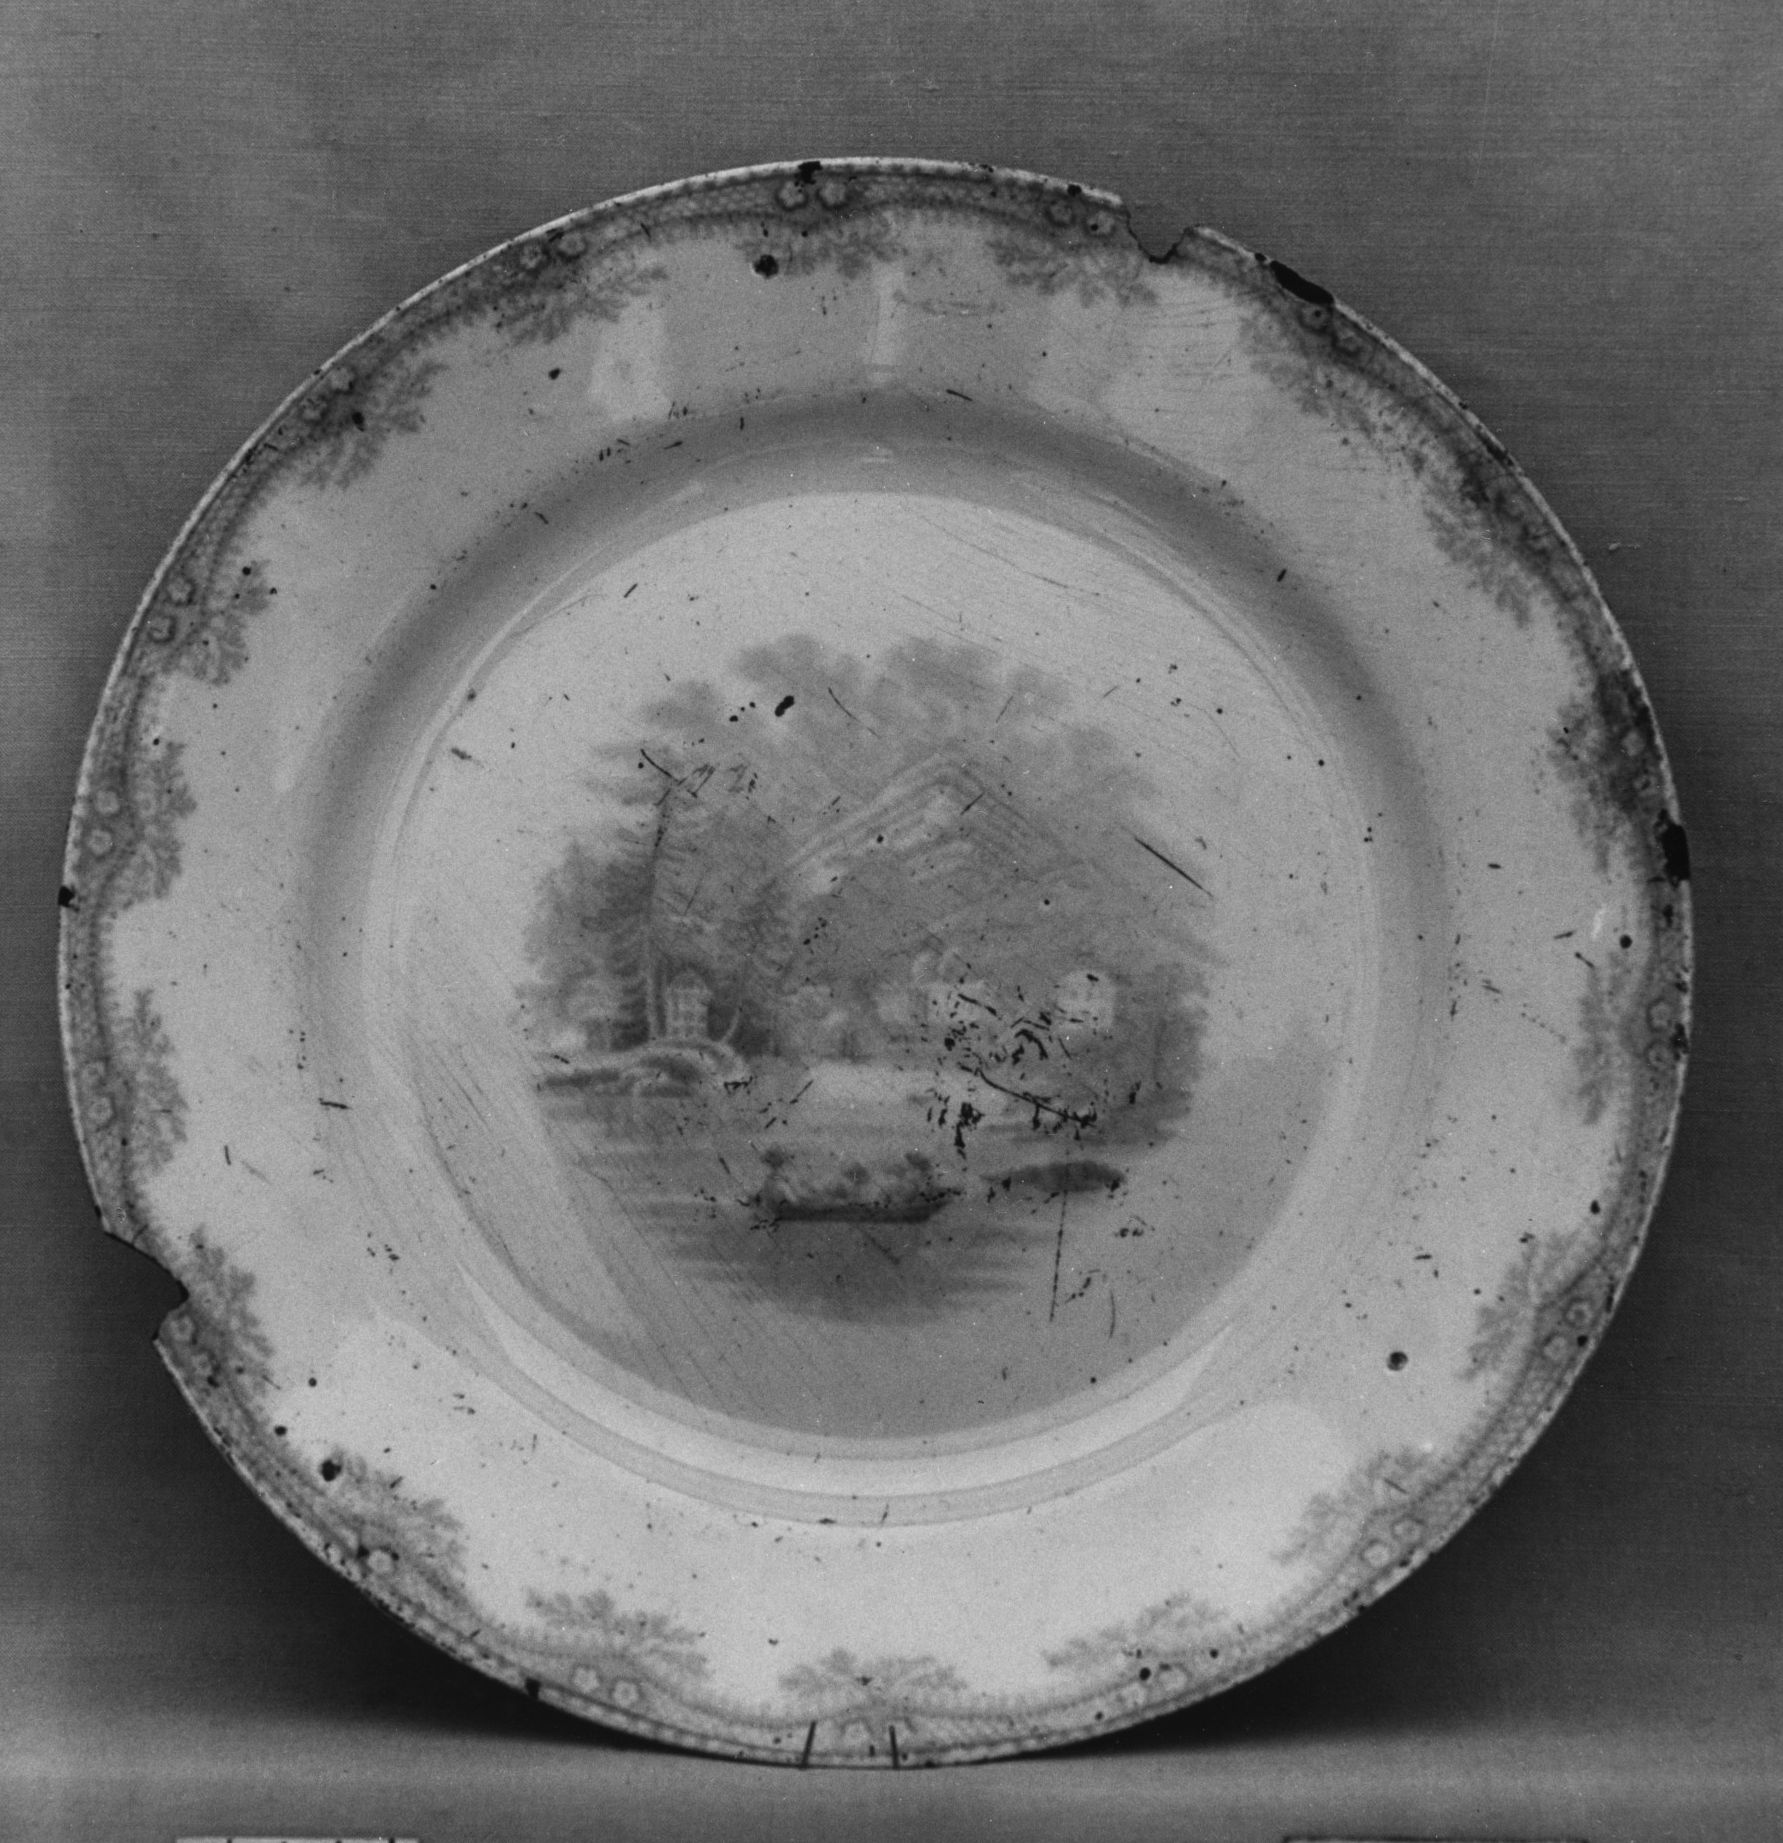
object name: plate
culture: british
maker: william ridgway & co.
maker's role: maker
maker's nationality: british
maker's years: 1834-1854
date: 1840-1854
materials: earthenware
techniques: transfer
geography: england